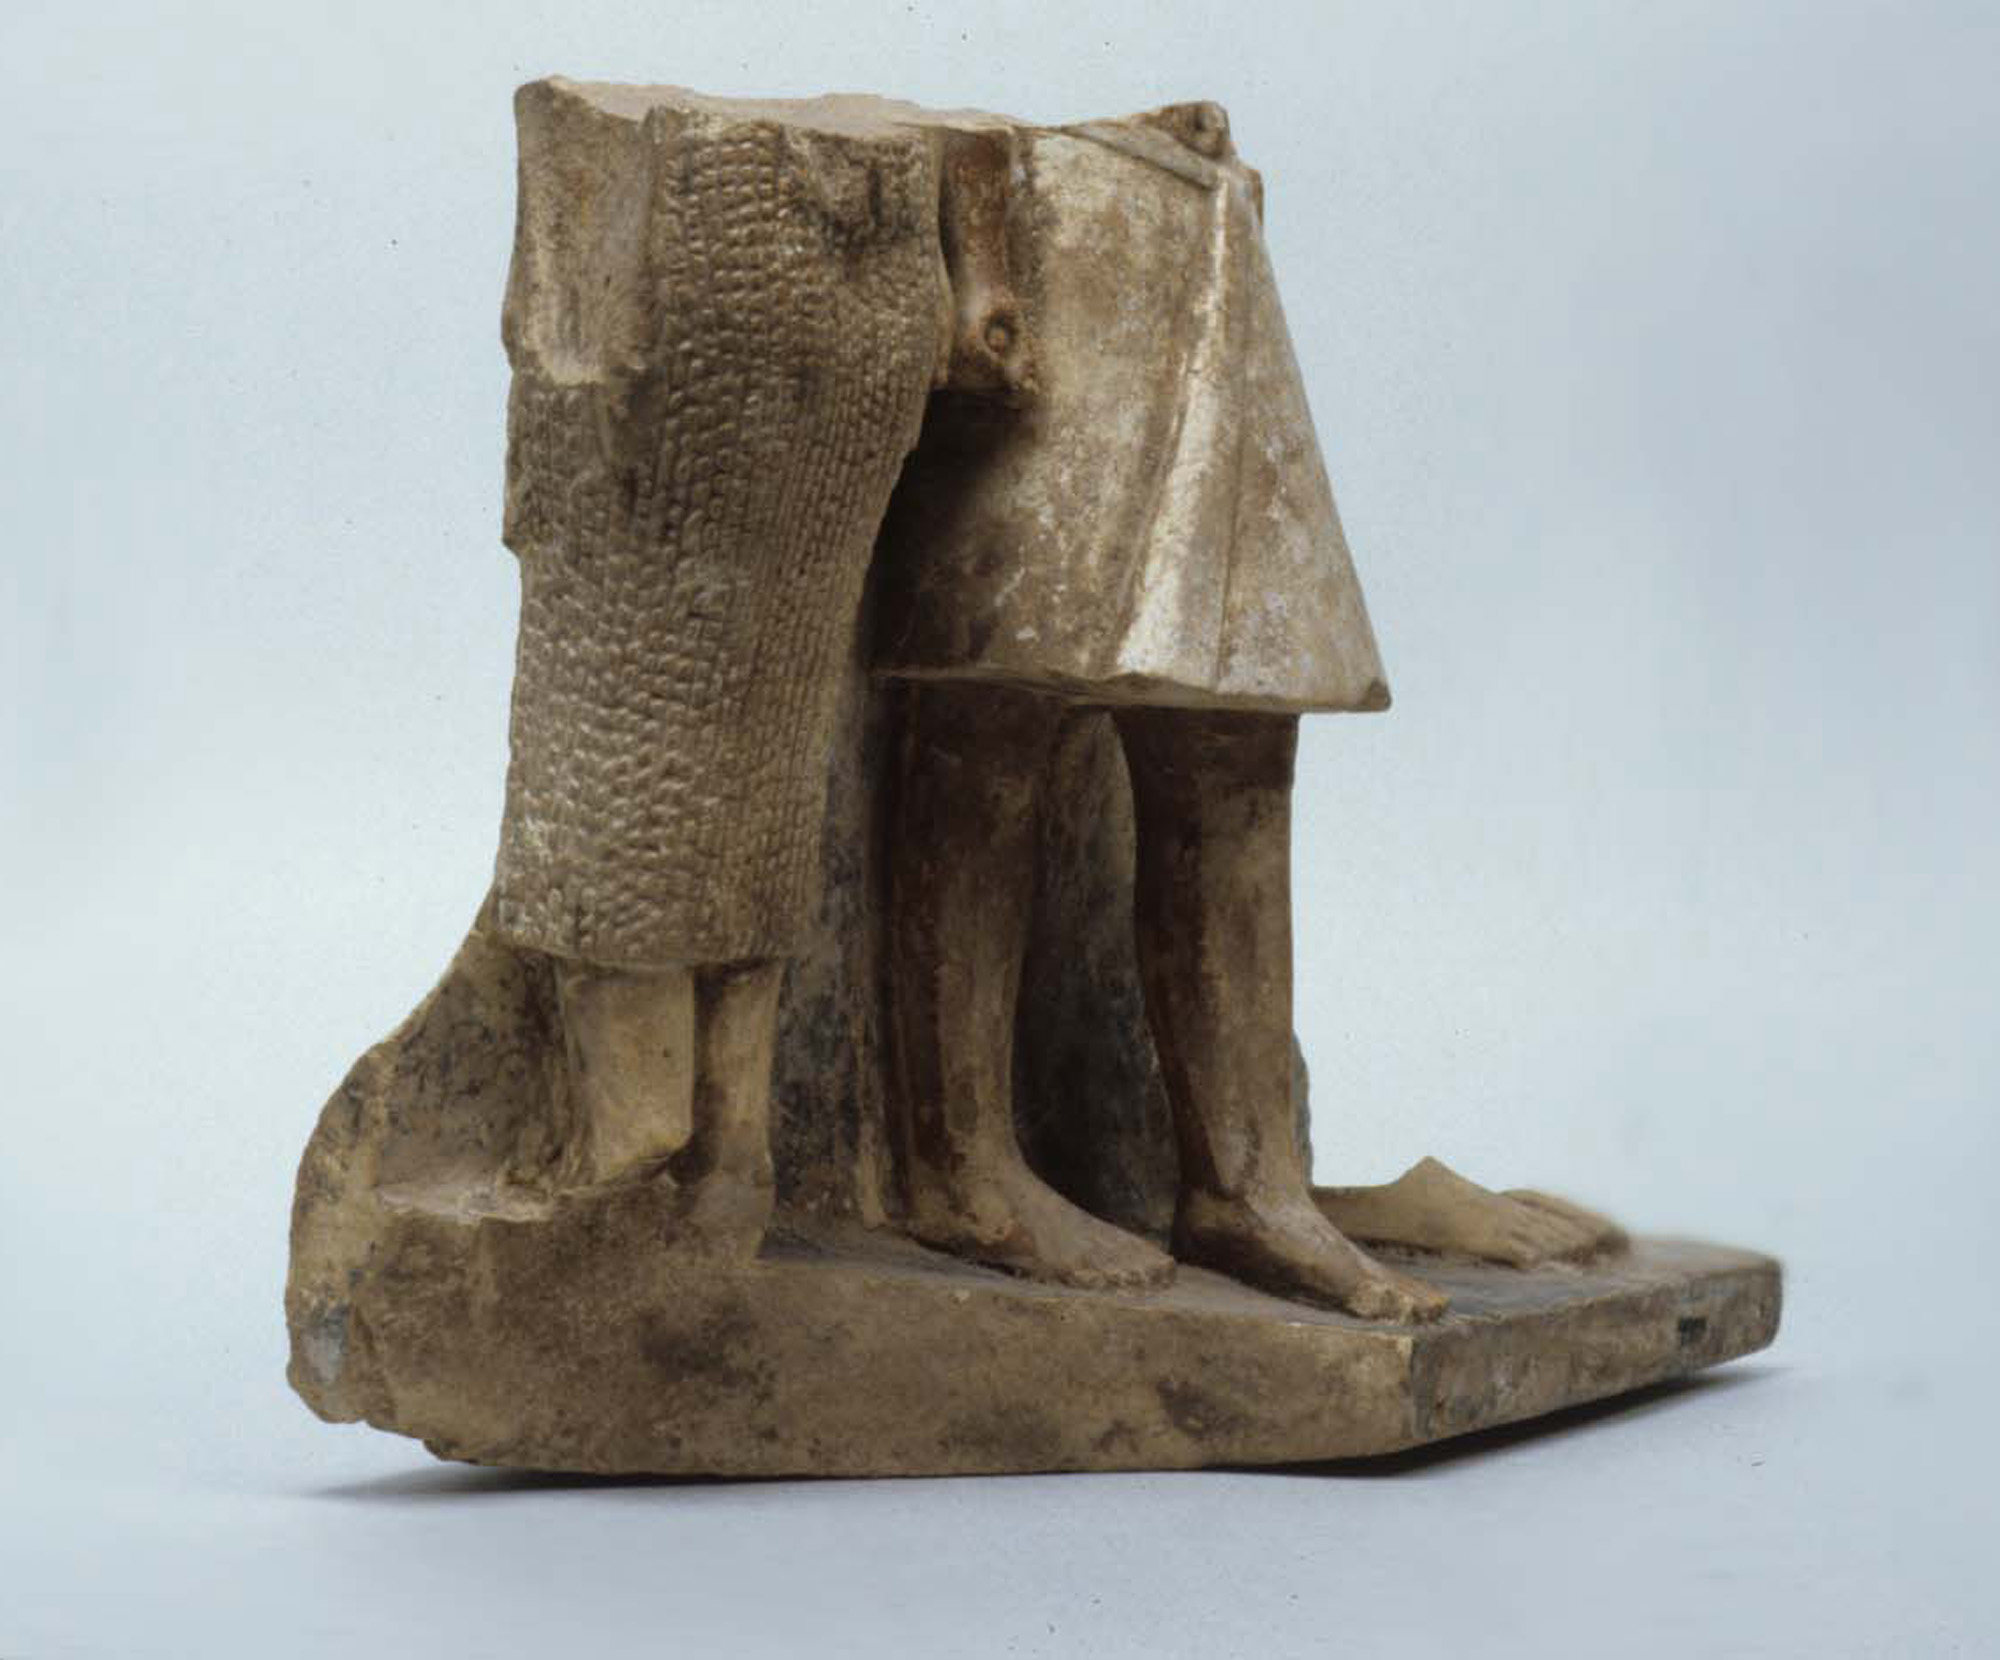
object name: statue group, lower section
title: Group statue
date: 2575-2465 BCE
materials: limestone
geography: southern upper egypt